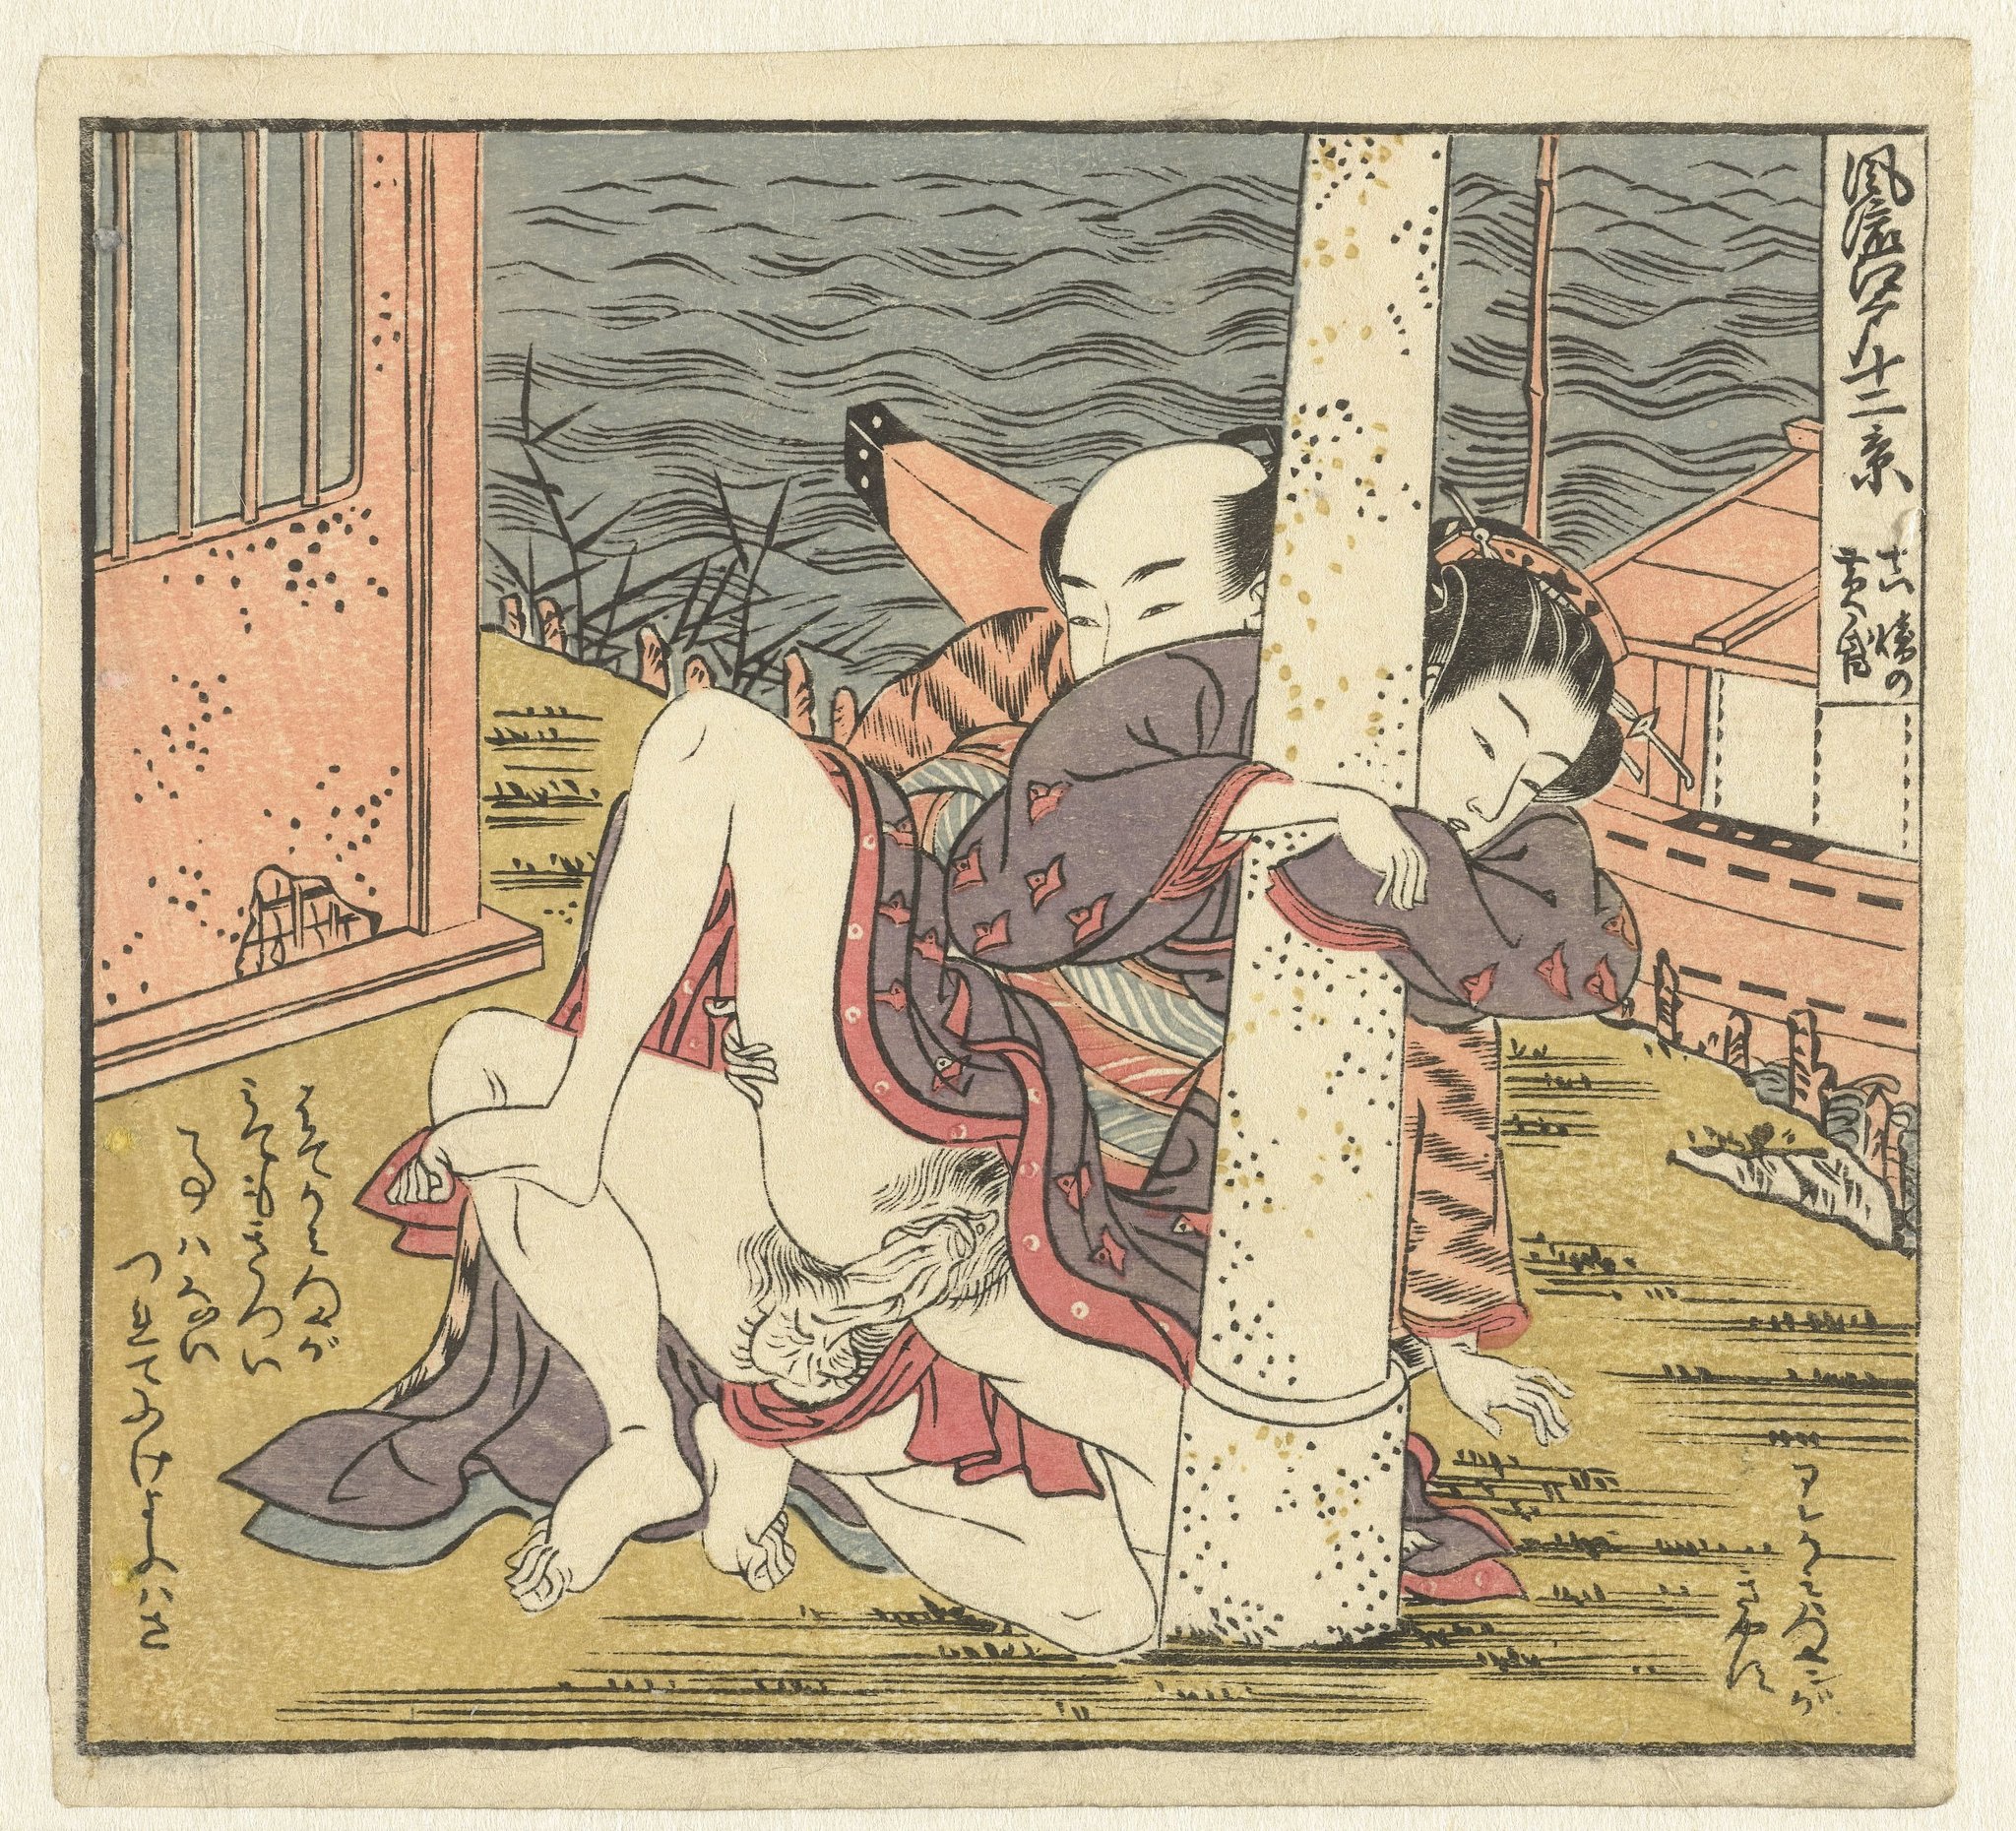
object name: print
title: Liefdespaar bij torii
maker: isoda kôryûsai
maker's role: print maker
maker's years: 1735-1790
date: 1770-1775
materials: paper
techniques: woodcut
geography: japan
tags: coitus, cohabiting, sexual intercourse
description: Copulerend paar in zittende houding, de vrouw een pilaar van een torii (toegangspoort naar een Shinto heiligdom) omklemmend; de rivier de Sumida op de achtergrond.